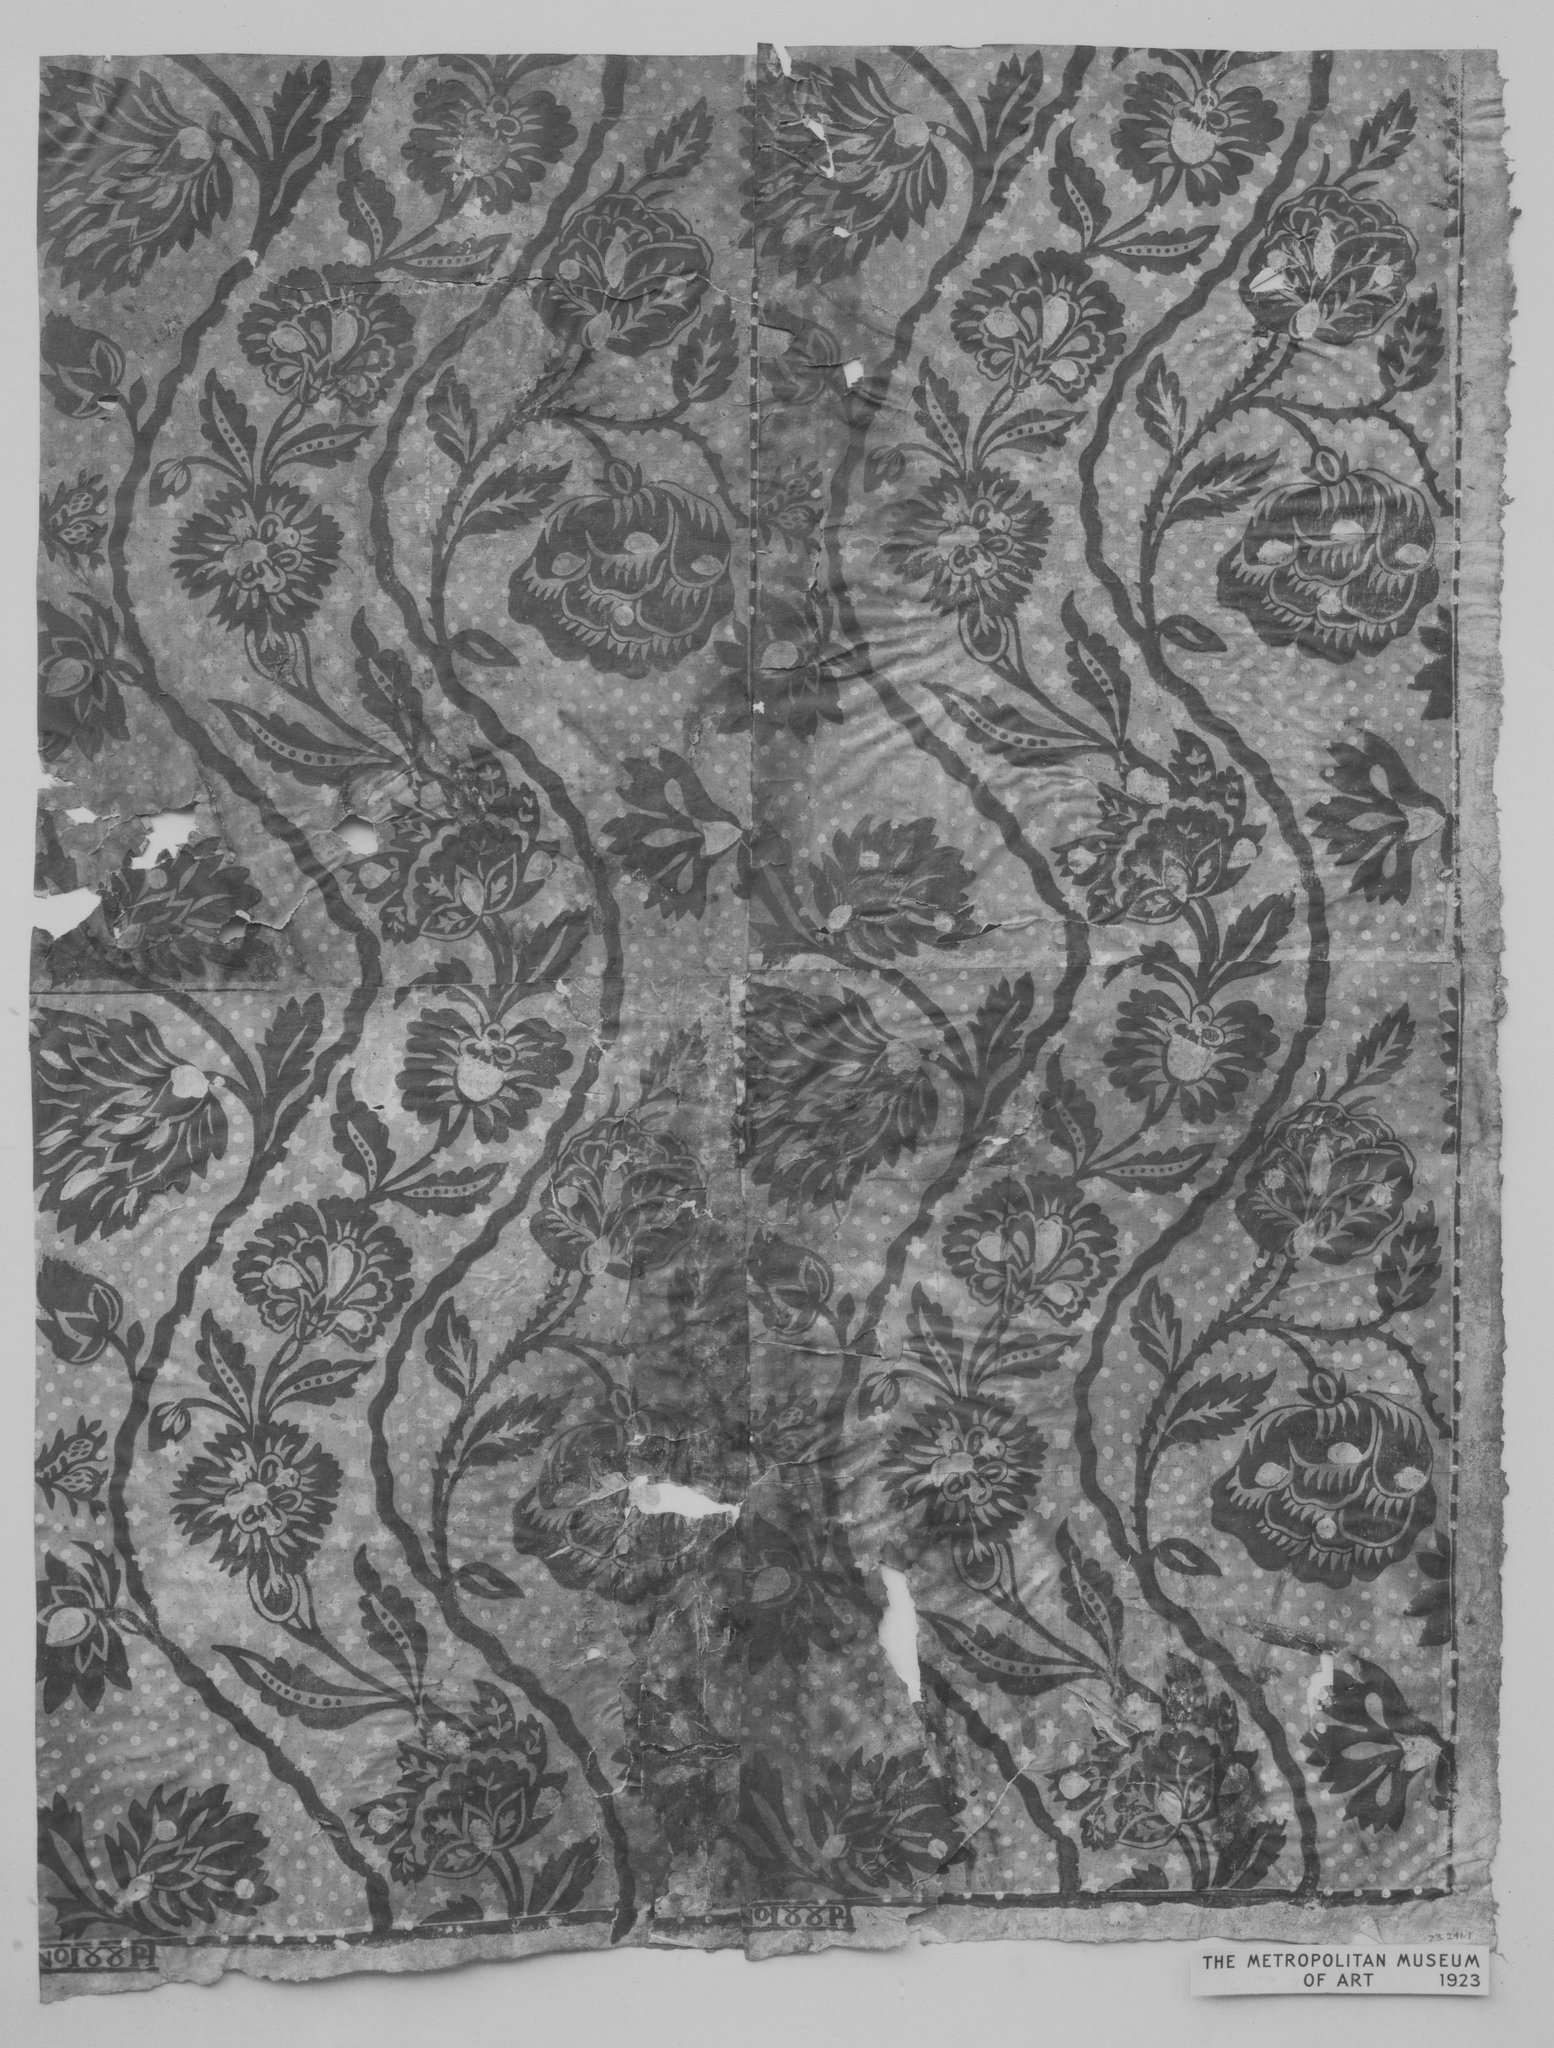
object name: wallpaper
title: Floral Wallpaper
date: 1701-1800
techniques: printing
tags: flowers,leaves